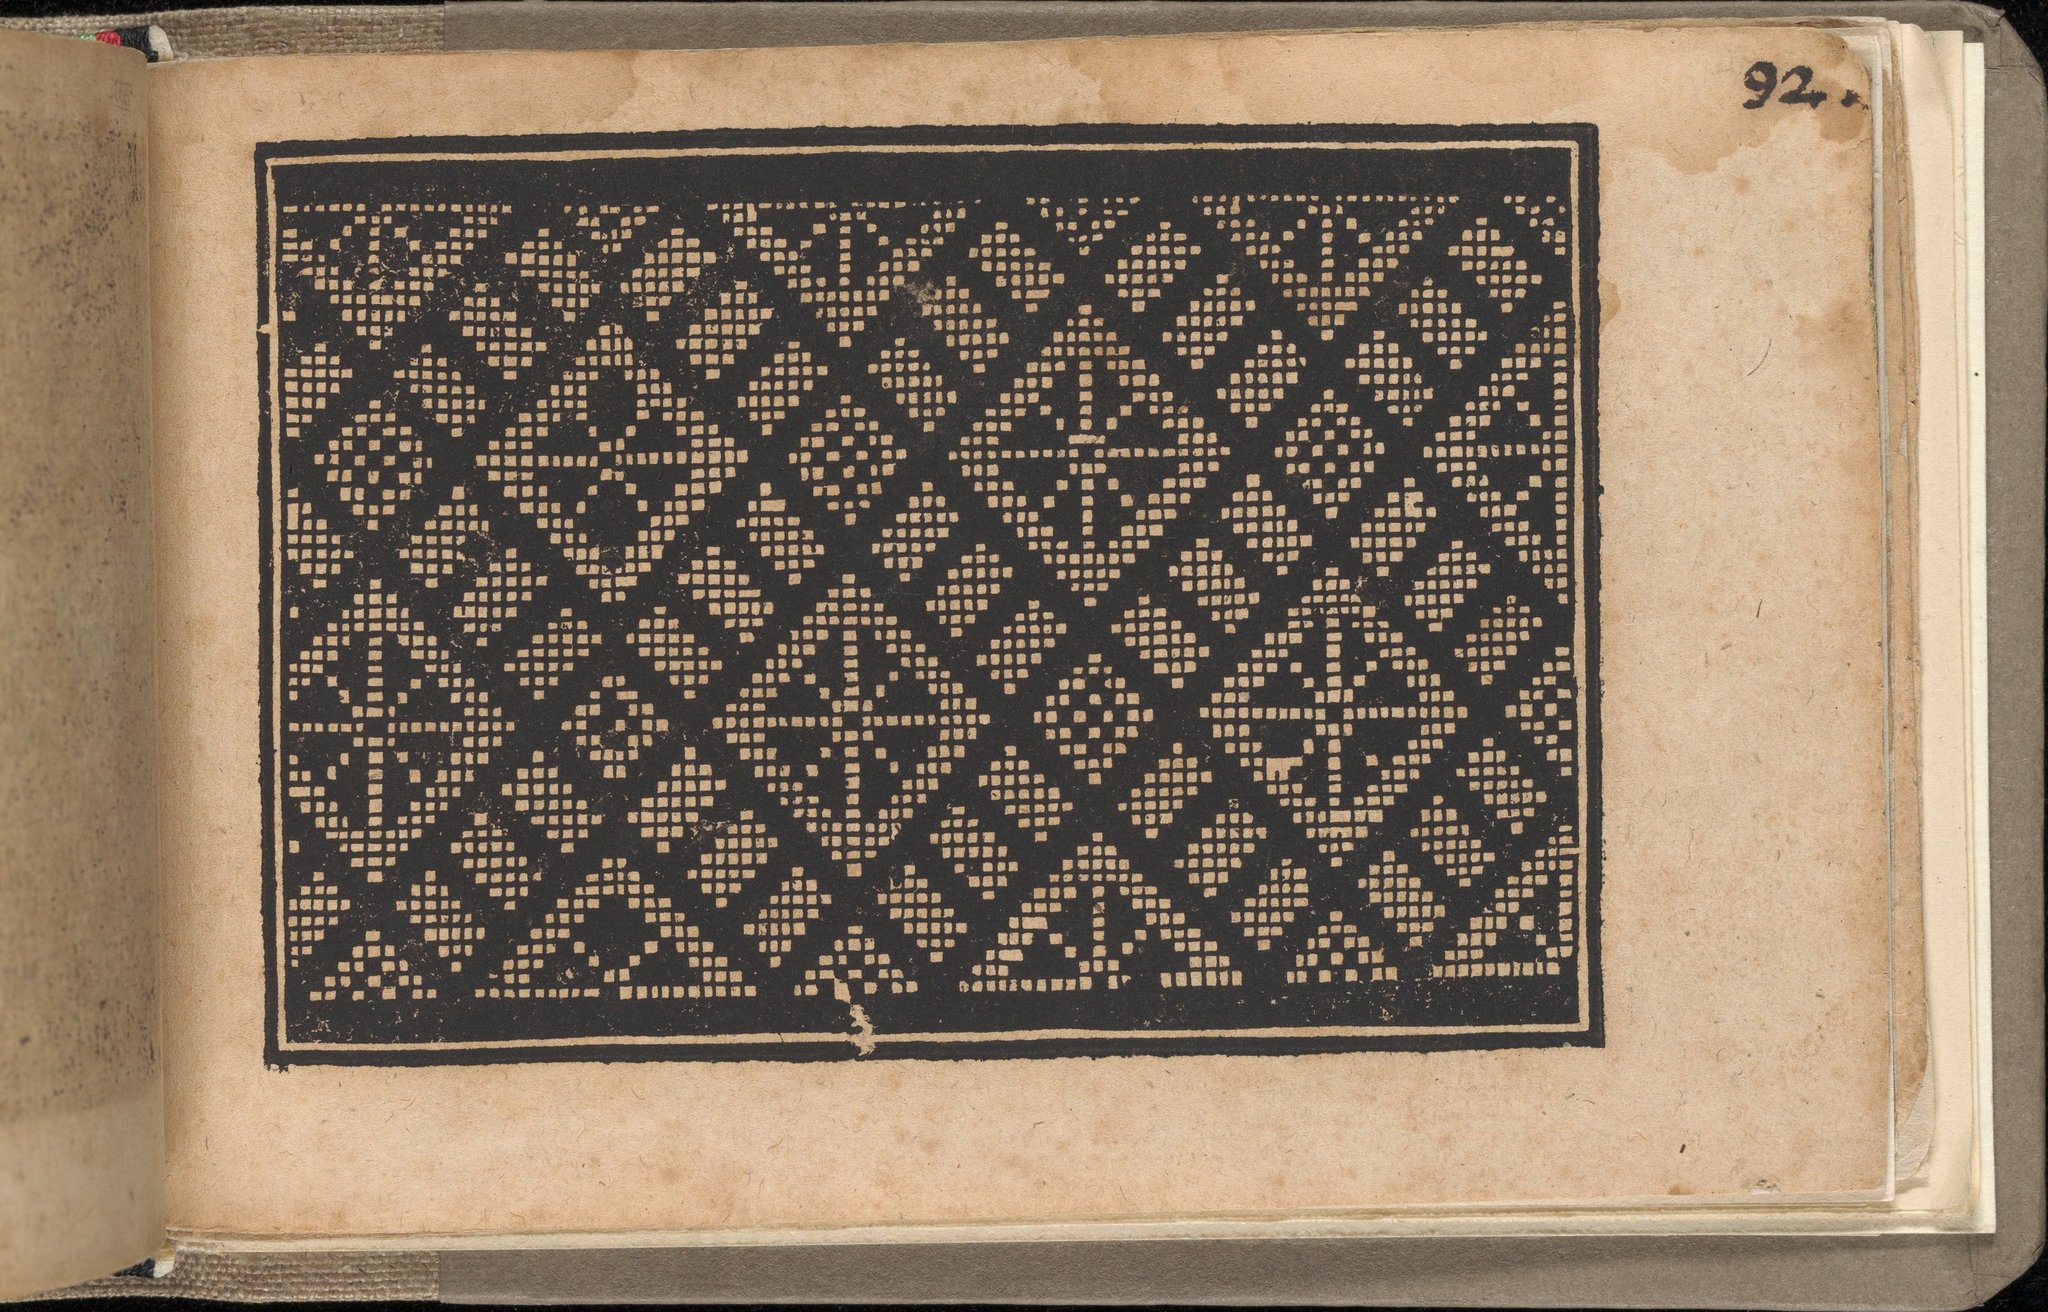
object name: book print ornament architecture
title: Schön newes Modelbuch (Page 92r)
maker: sigismundus latomus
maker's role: publisher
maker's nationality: german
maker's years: 1599-1632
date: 1608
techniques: woodcut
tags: ornament